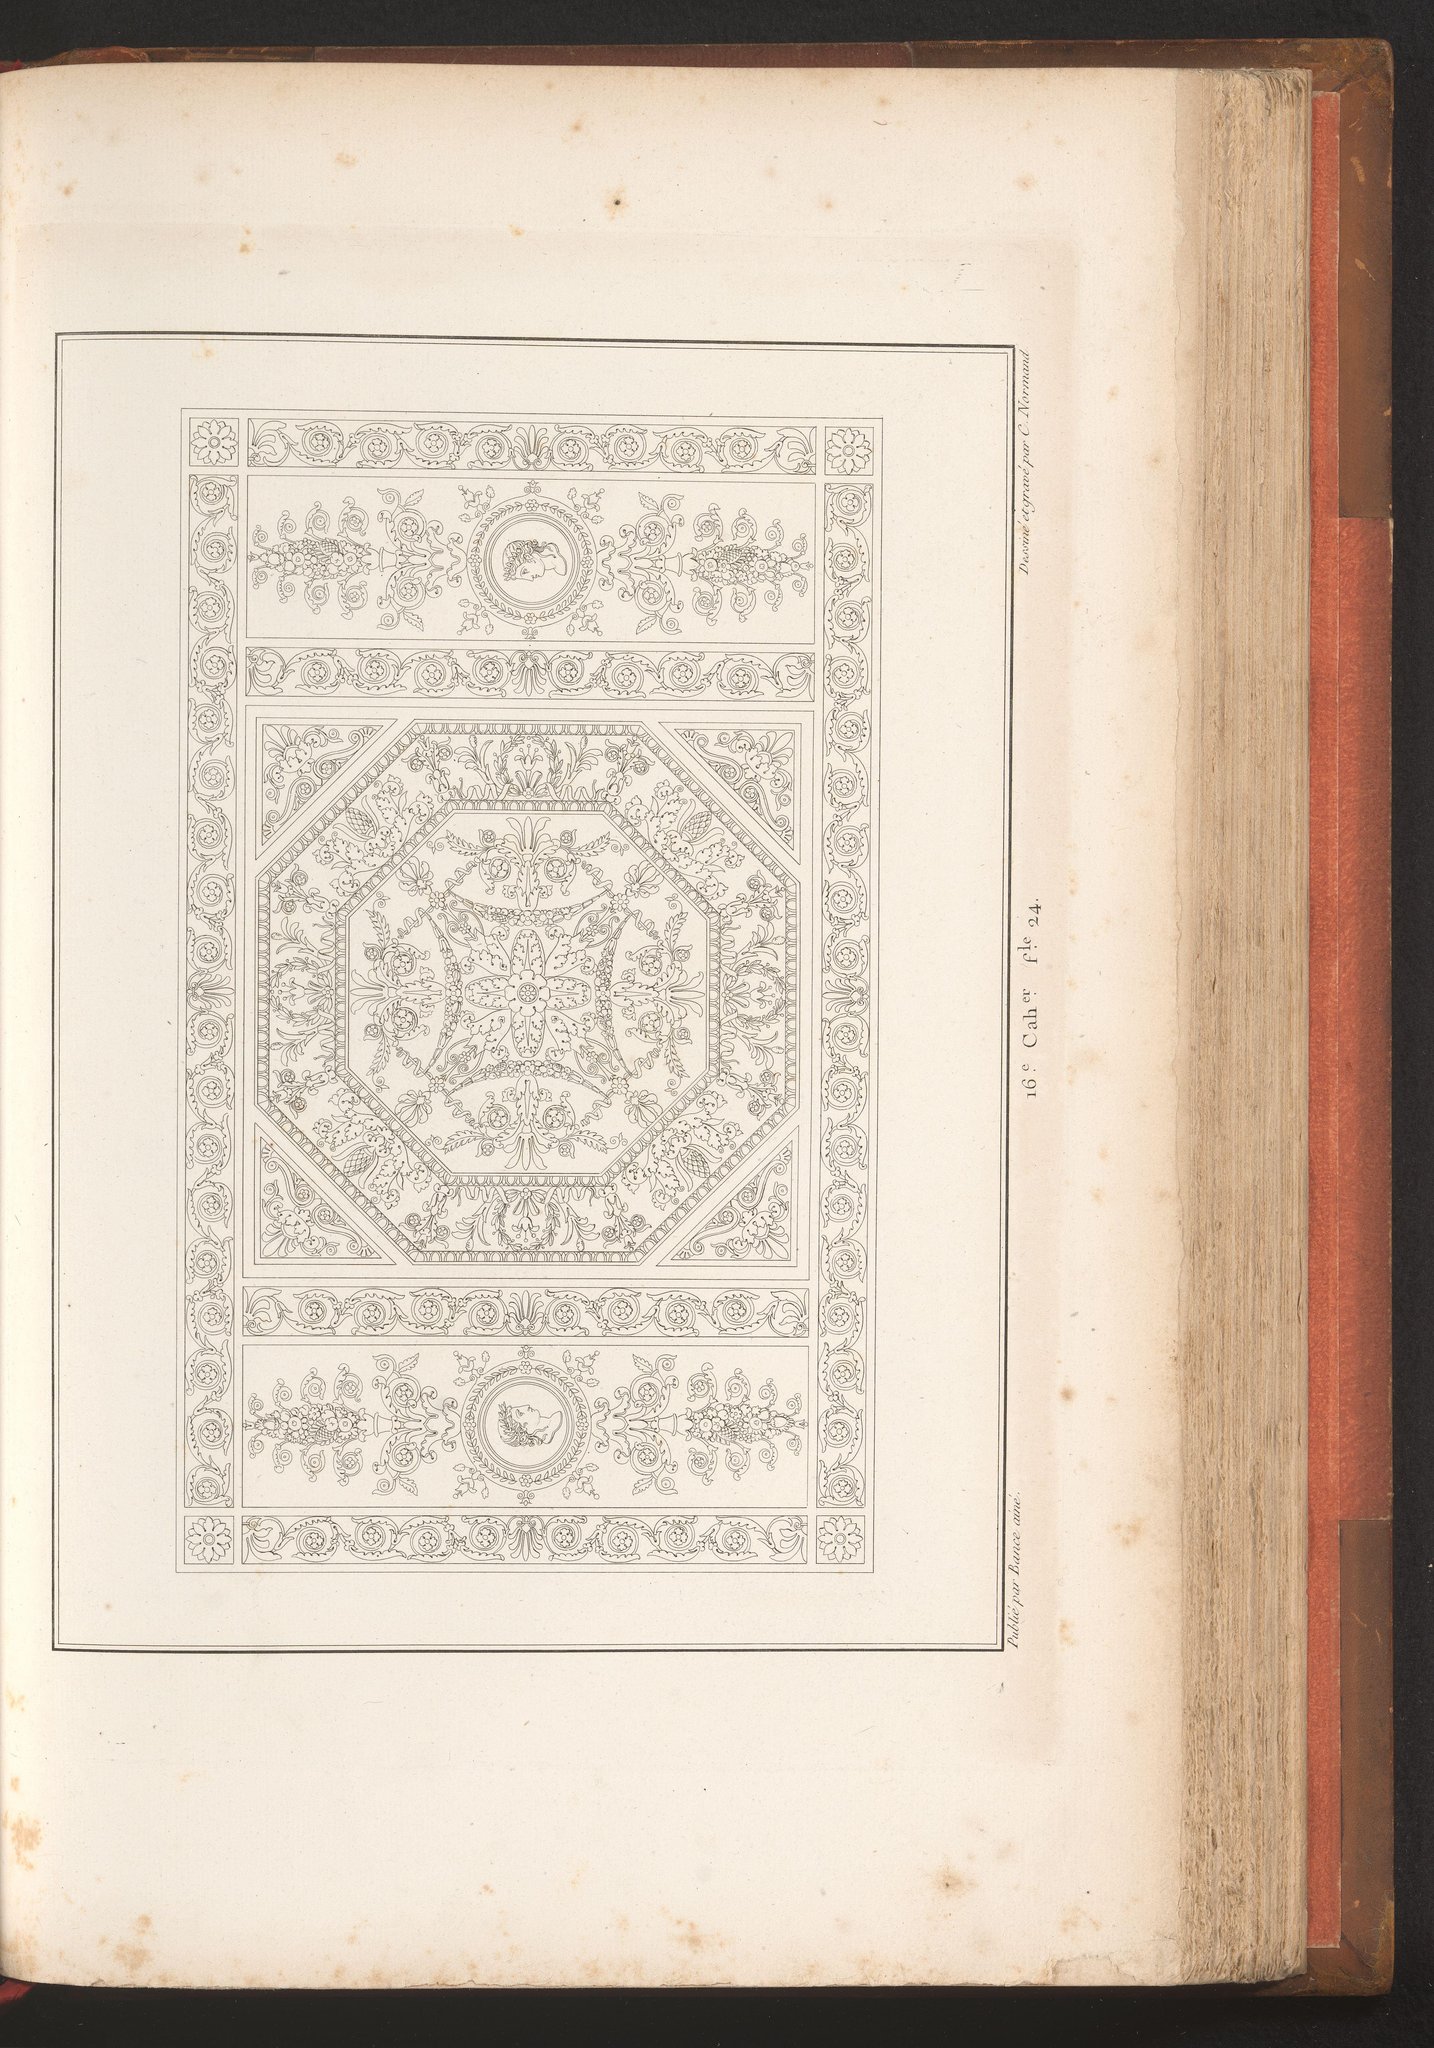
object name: ornament print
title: Plafond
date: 1820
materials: paper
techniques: etching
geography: paris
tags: ornaments ~ art, (decorated) ceiling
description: Ornamentprent met ontwerp voor plafond. Onderdeel (16e. Cah. f.le 24) van het prentalbum met twee series van in totaal 138 ornamentprenten door Beauvallet en Normand, 'Fragmens d'Ornemens dans le Style Antique'.